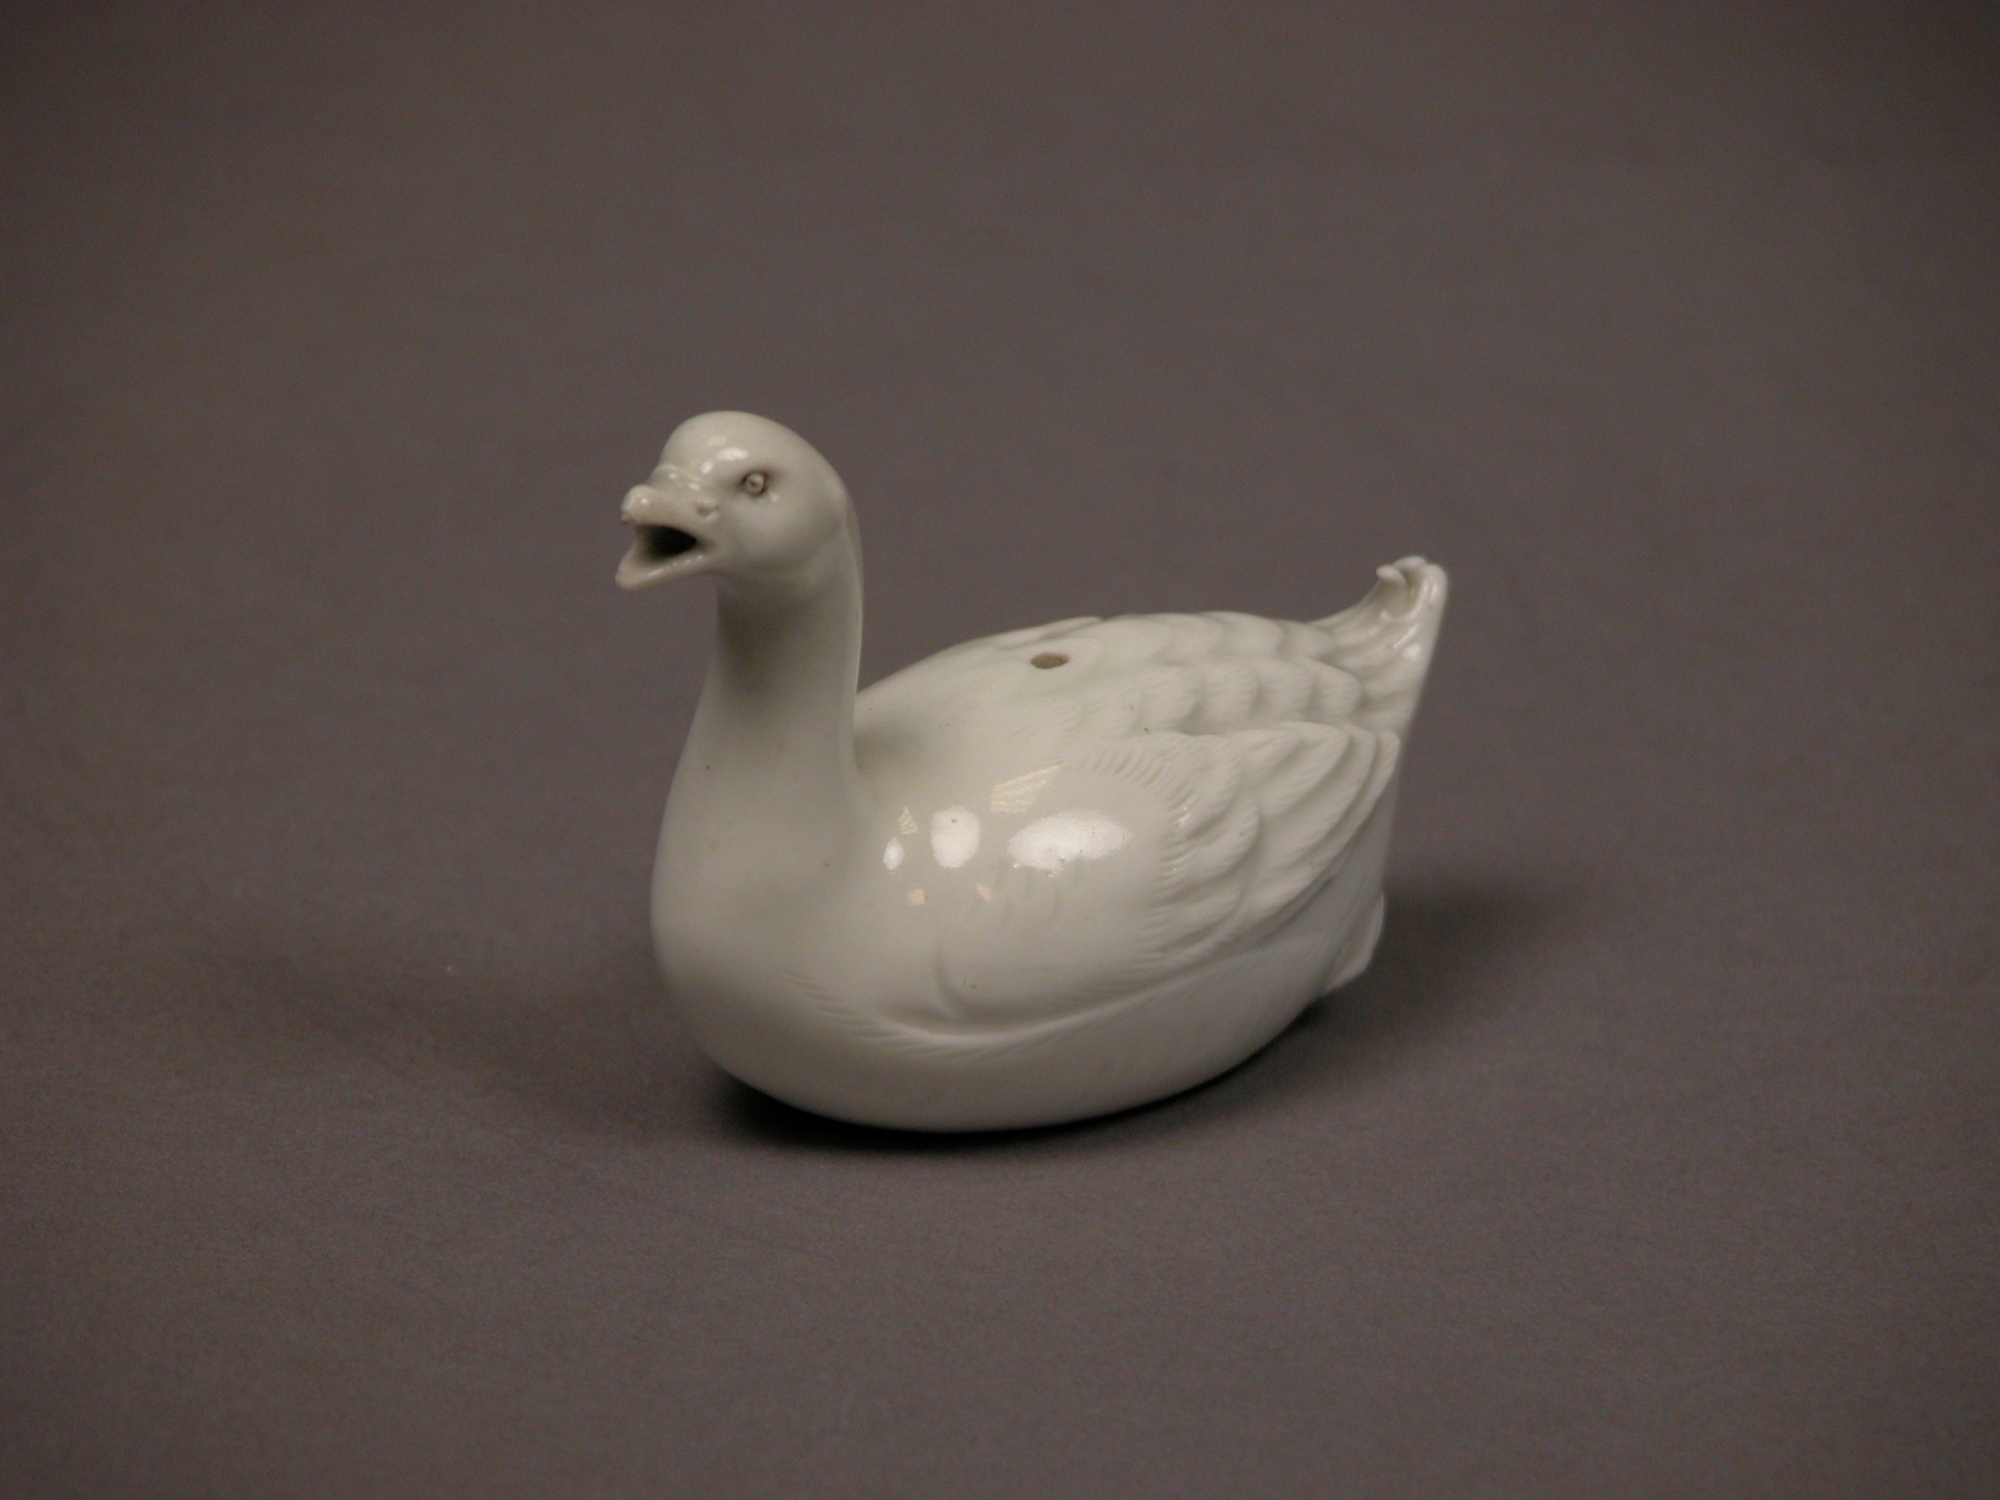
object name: water holder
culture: japanese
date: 1820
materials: porcelain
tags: ducks